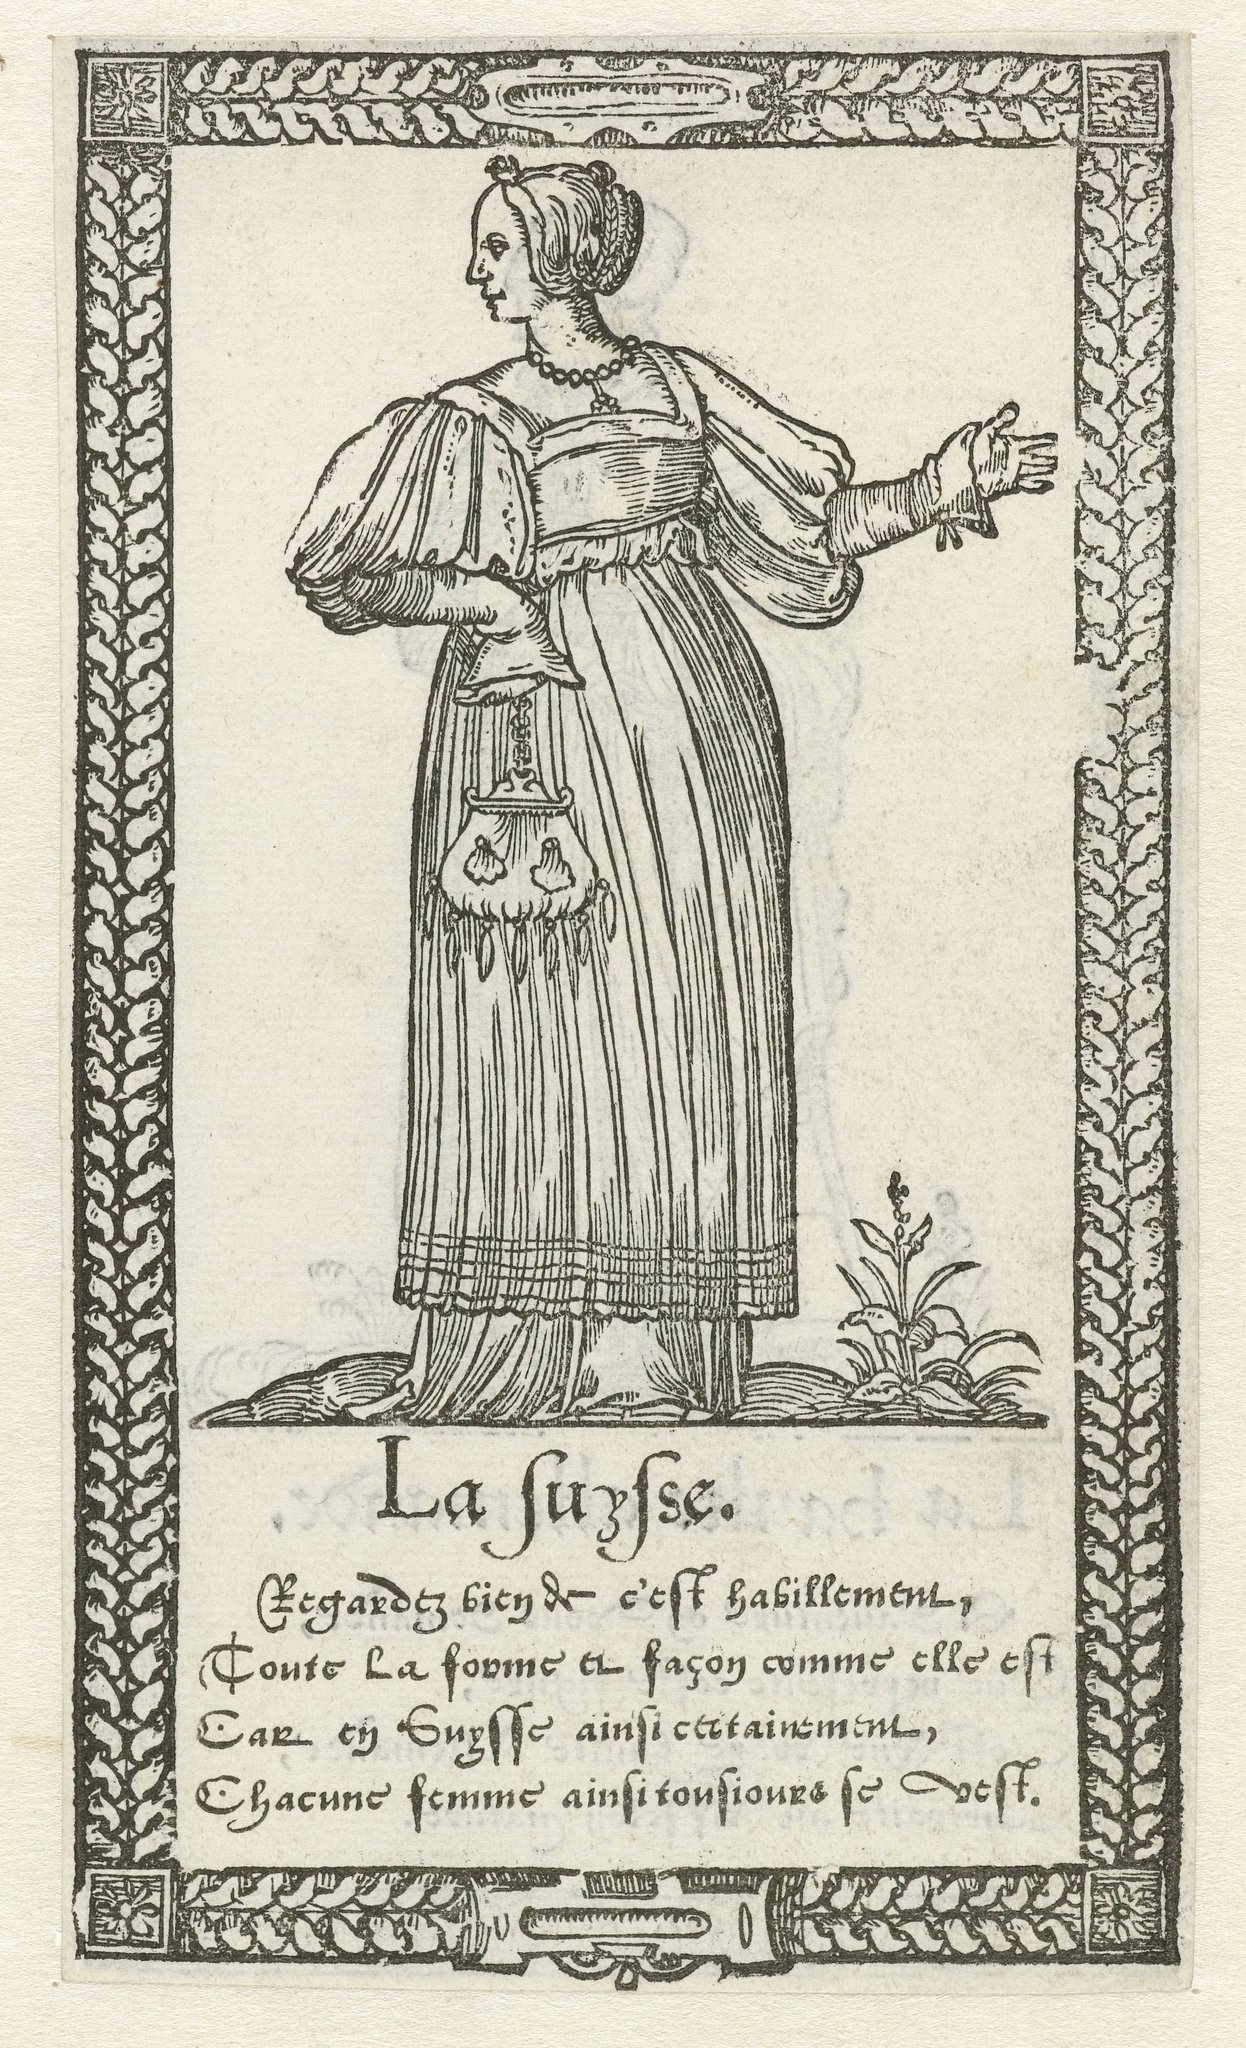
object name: print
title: Recueil de la diversité des habits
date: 1562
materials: paper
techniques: woodcut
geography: paris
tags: fashion plates, europeans (swiss) (+ costume), folk costume, regional costume, dress, gown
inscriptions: collector's mark: Lugt 2228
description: Dit is prent 61 uit een serie van 121. Binnen deze serie zijn er prenten gemaakt naar voorbeelden van Jean-François de Roberval en Enea Vico, onbekend welke precies.